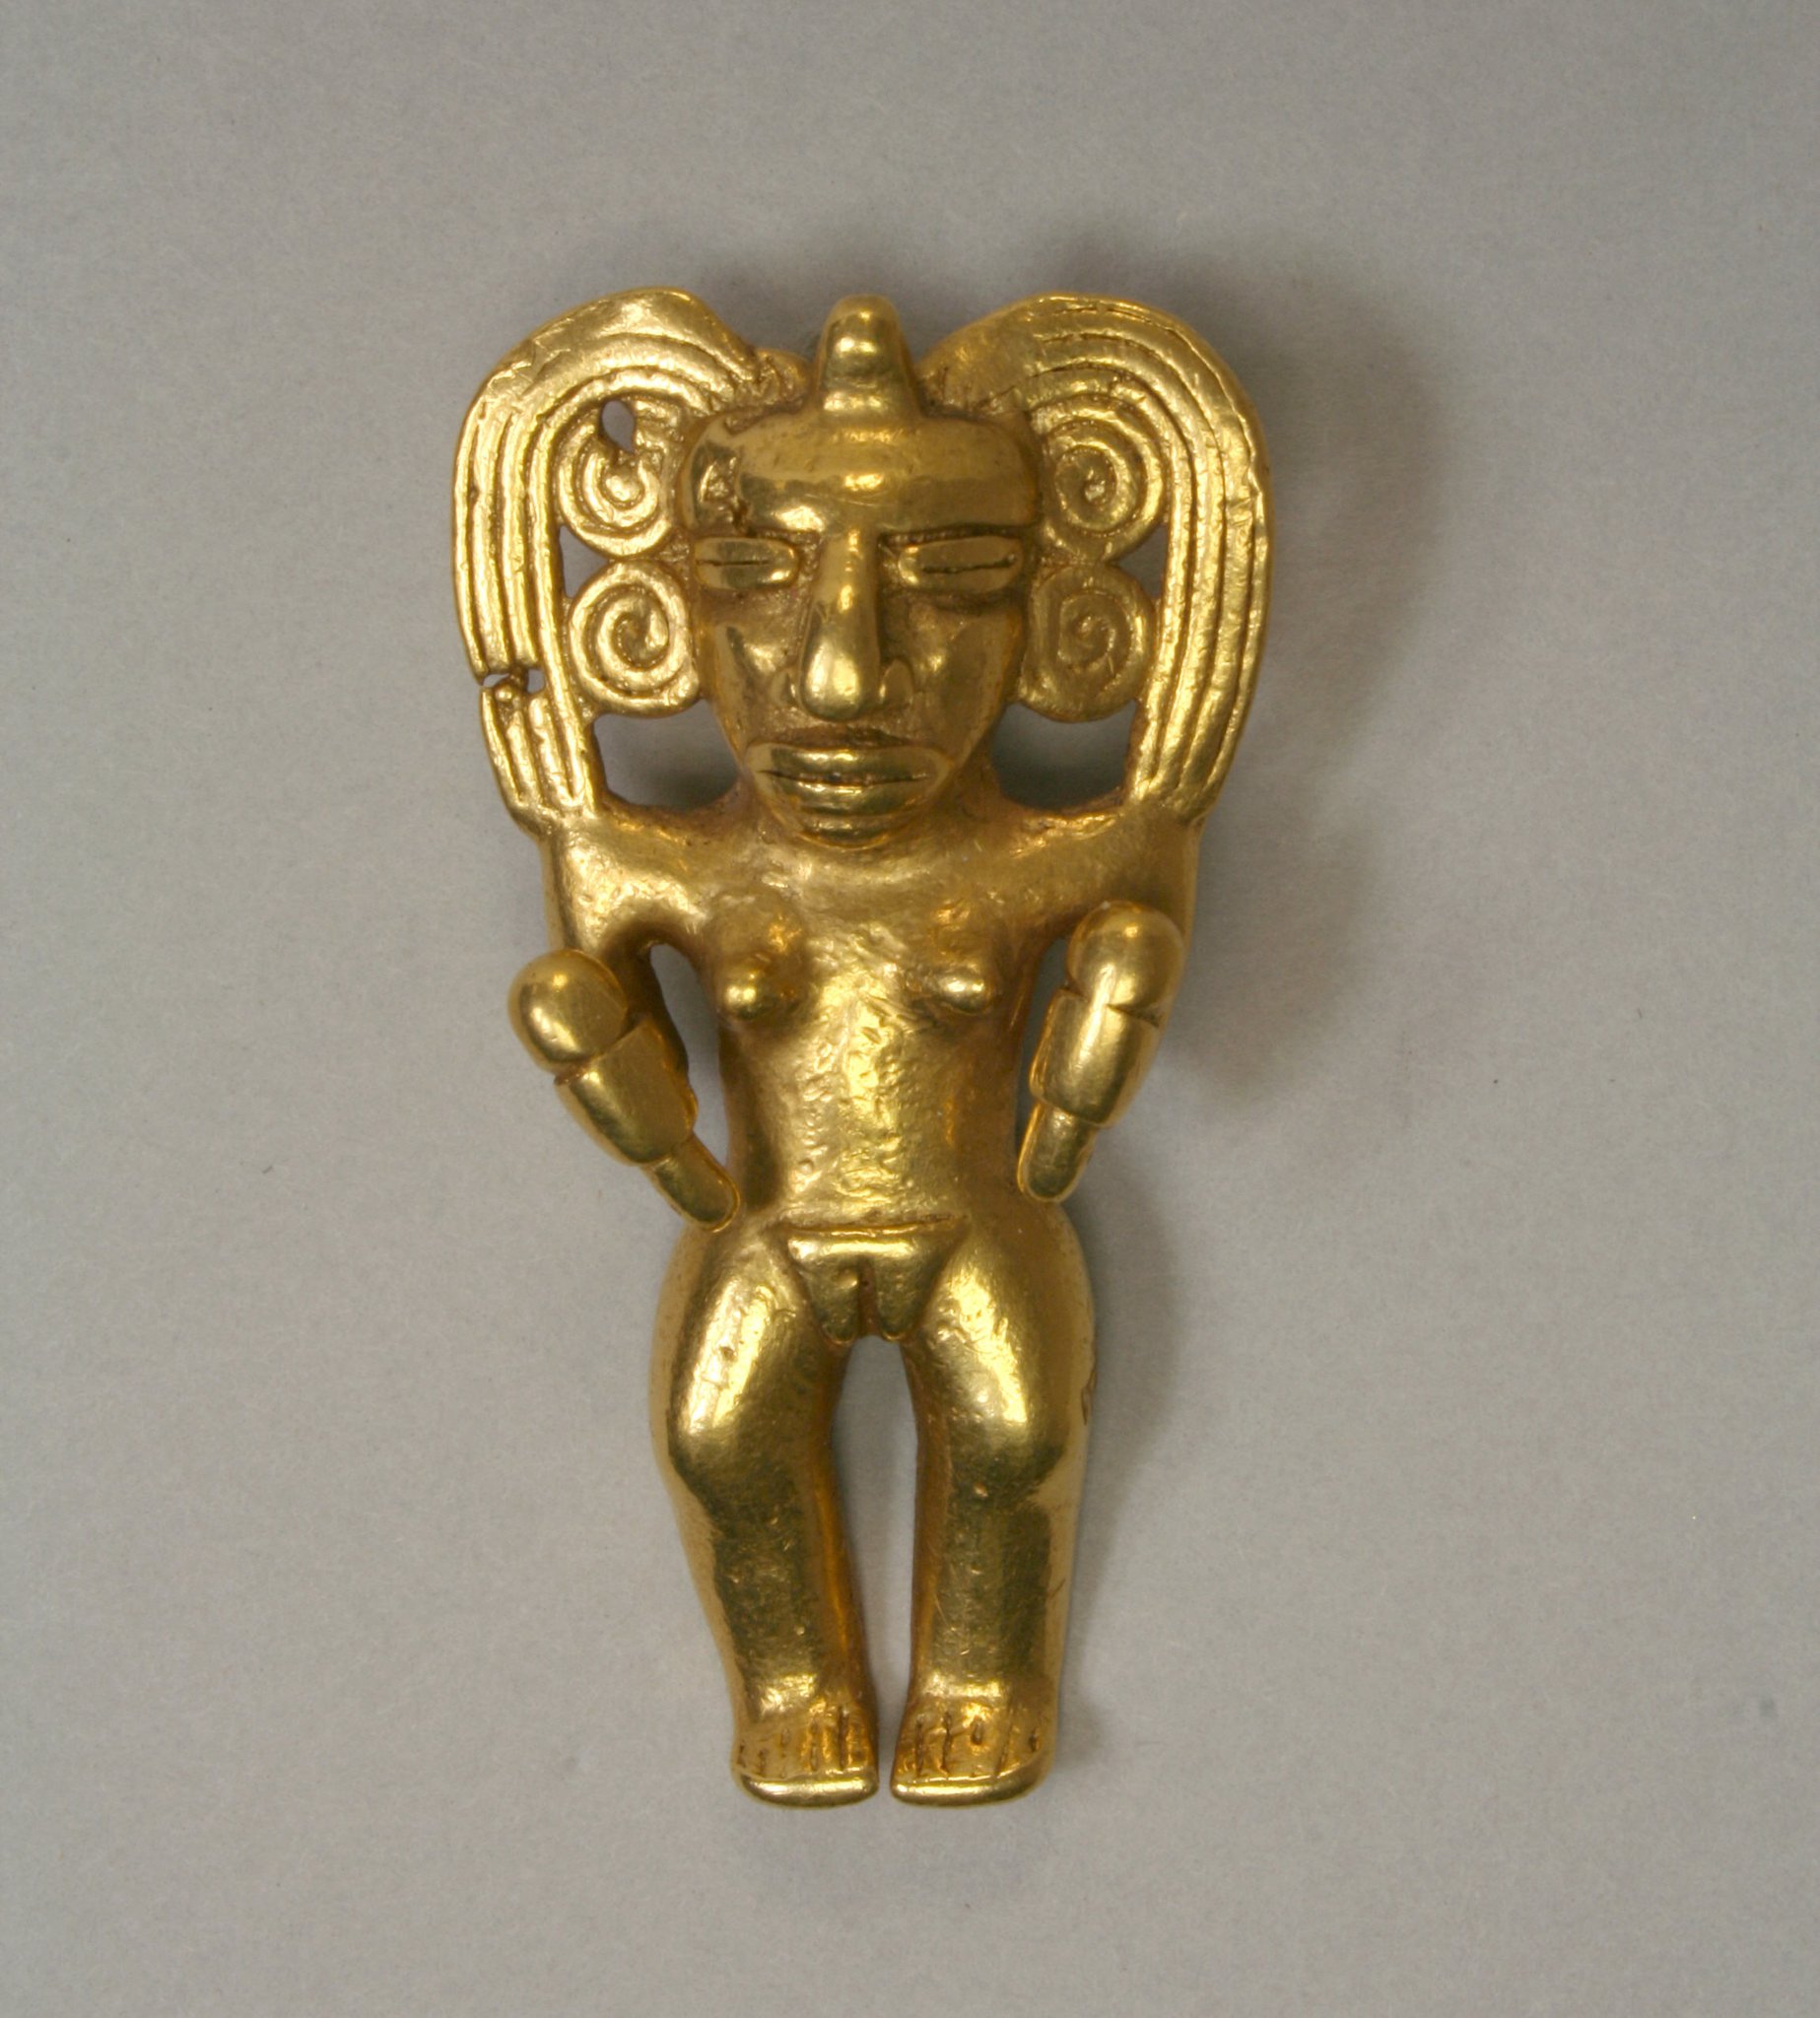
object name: pendant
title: Figure Pendant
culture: calima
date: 401-1000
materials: gold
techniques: casting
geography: colombia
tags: women